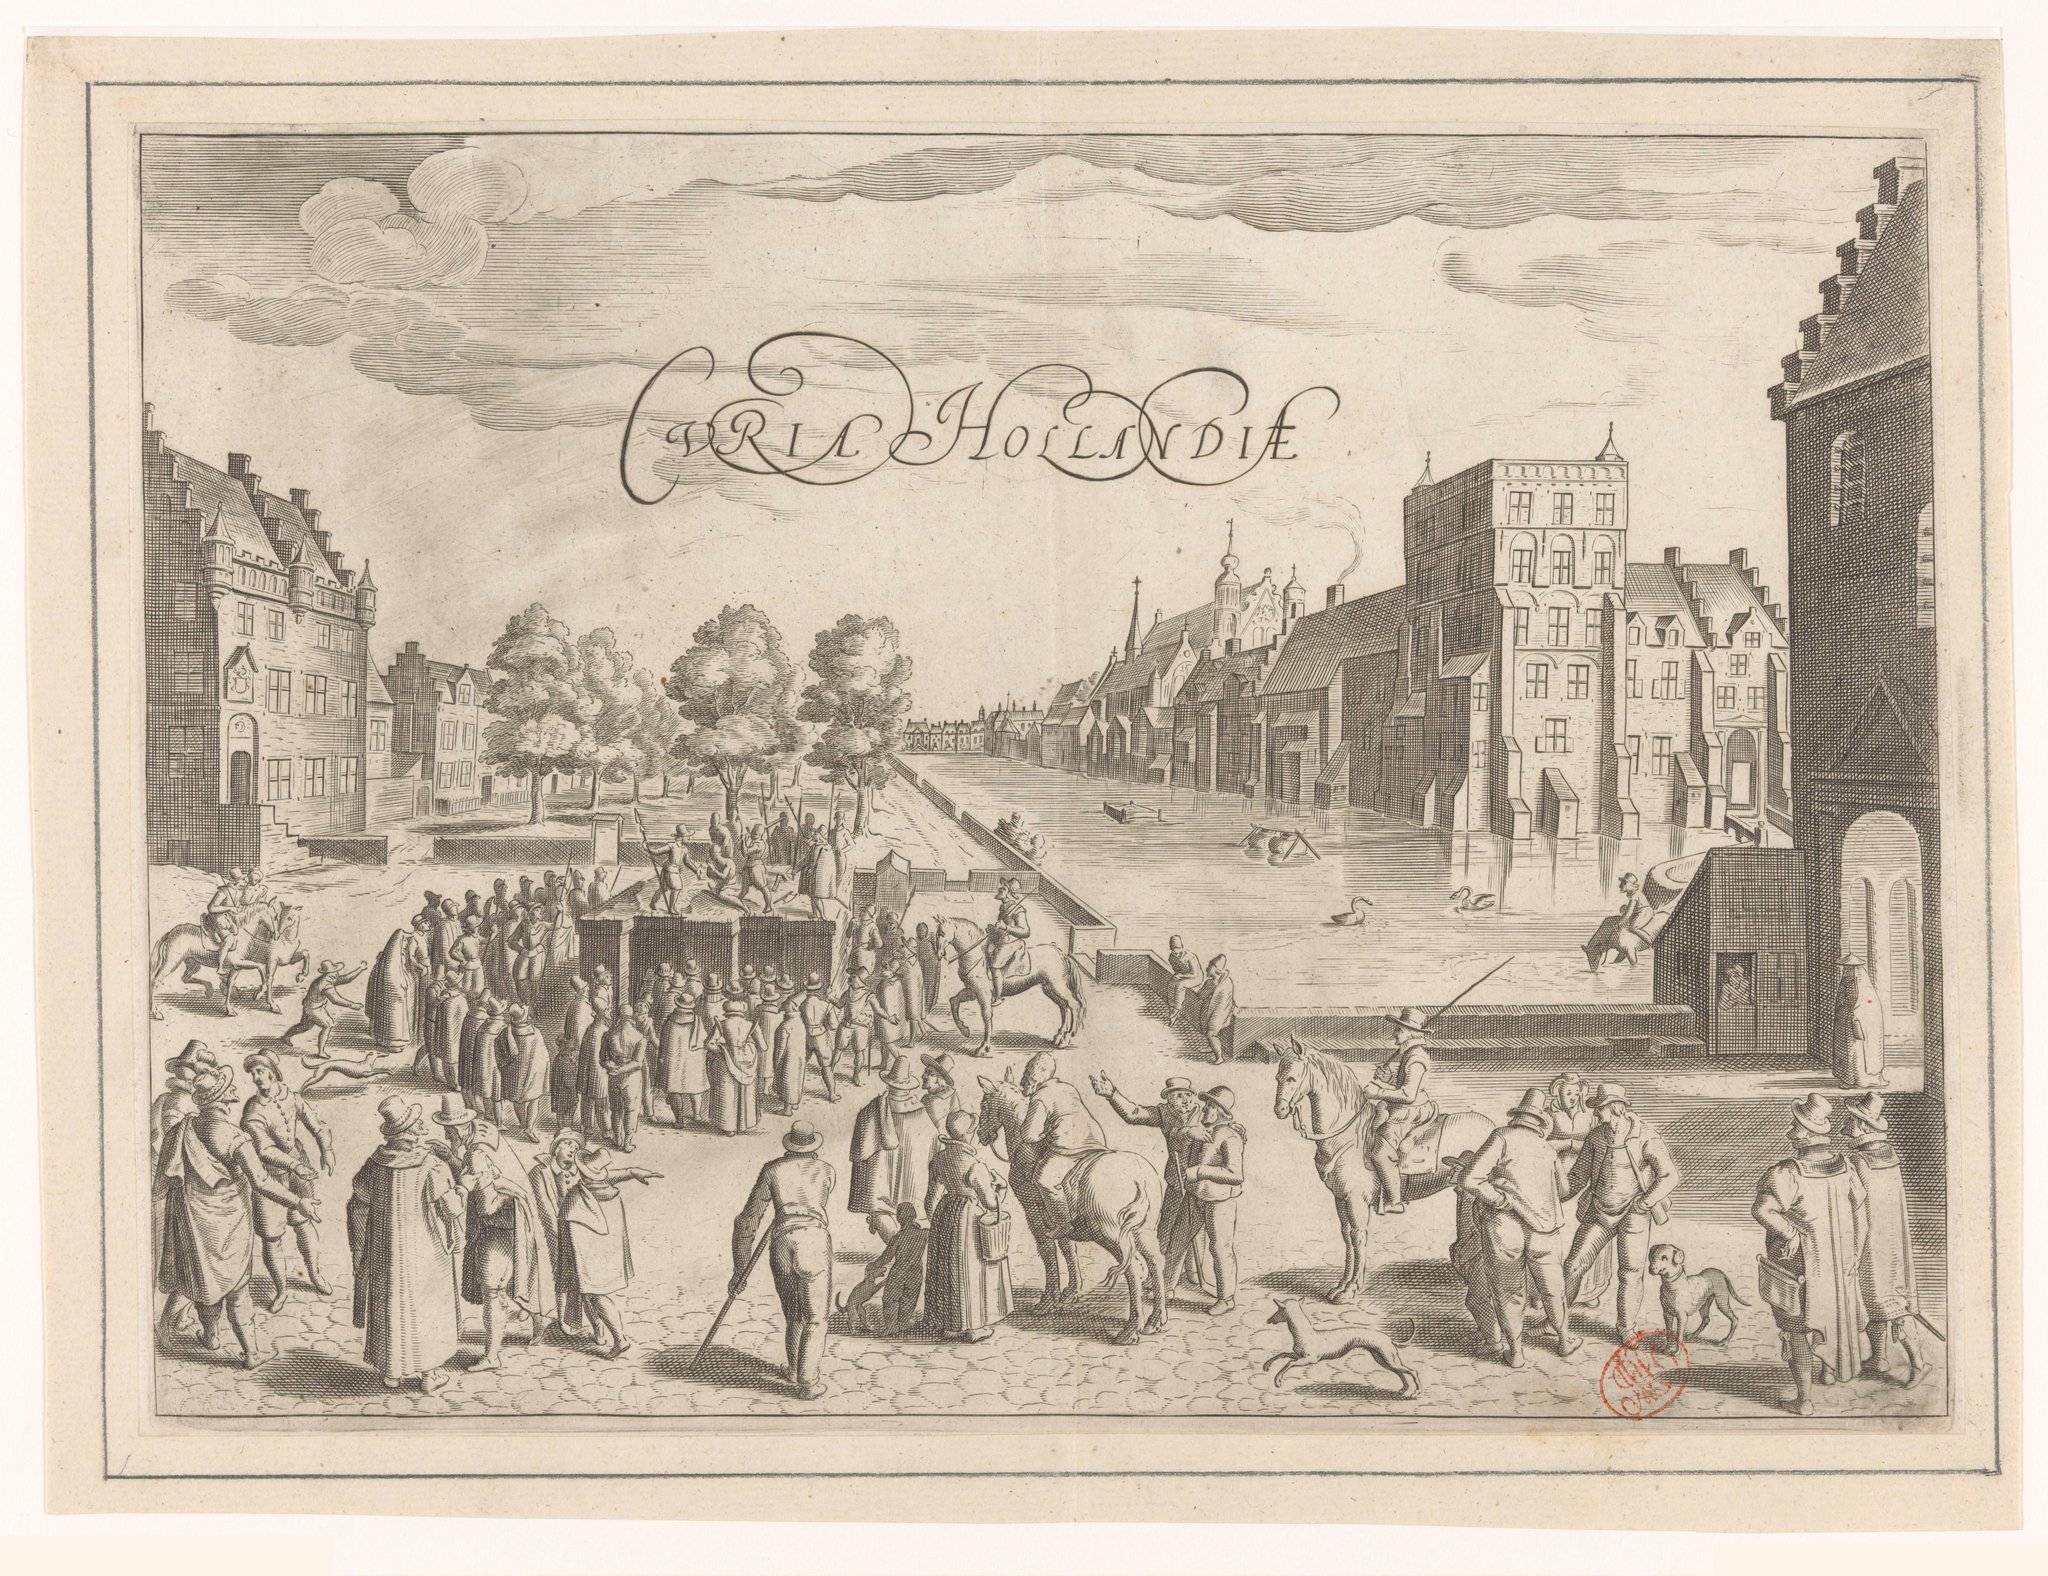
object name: print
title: Het Hof van Holland, ca. 1610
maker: bartholomeus willemsz. dolendo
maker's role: print maker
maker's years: 1560-1626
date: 1610-1612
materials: paper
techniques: engraving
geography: leiden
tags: on the scaffold or place of execution, violent death by beheading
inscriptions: collector's mark: Lugt 2228, collector's mark: Lugt 195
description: Prent ook gebruikt in: Orlers, Jan Jansz. Den Nassauschen Lauren-Crans: Beschrijvinghe ende af-beeldinge van alle de victorien (...) die Godt Almachtich de (...) Staten der Vereenichde Neder-landen verleent heeft, deur het wijs ende clouck beleyt des Hooch-ghebooren Fursts Maurits van Nassau. Leiden: Jan Jansz. Orlers en Henrick Lodewijcxsoon van Haestens, 1610, fol. 6/7. En in: Orlers, Jan Jansz. Les lauriers de Nassau: Description & representation de toutes les victoires […] lesquelles Dieu a octroiees aux […] Estats des Provinces Unies du Païs-Bas, souz la conduite & gouuernement de Son Excellence, le prince Maurice de Nassau. Leiden: Jan Jansz. Orlers en Henrick Lodewijcxsoon van Haestens, 1612, fol. 8/9.